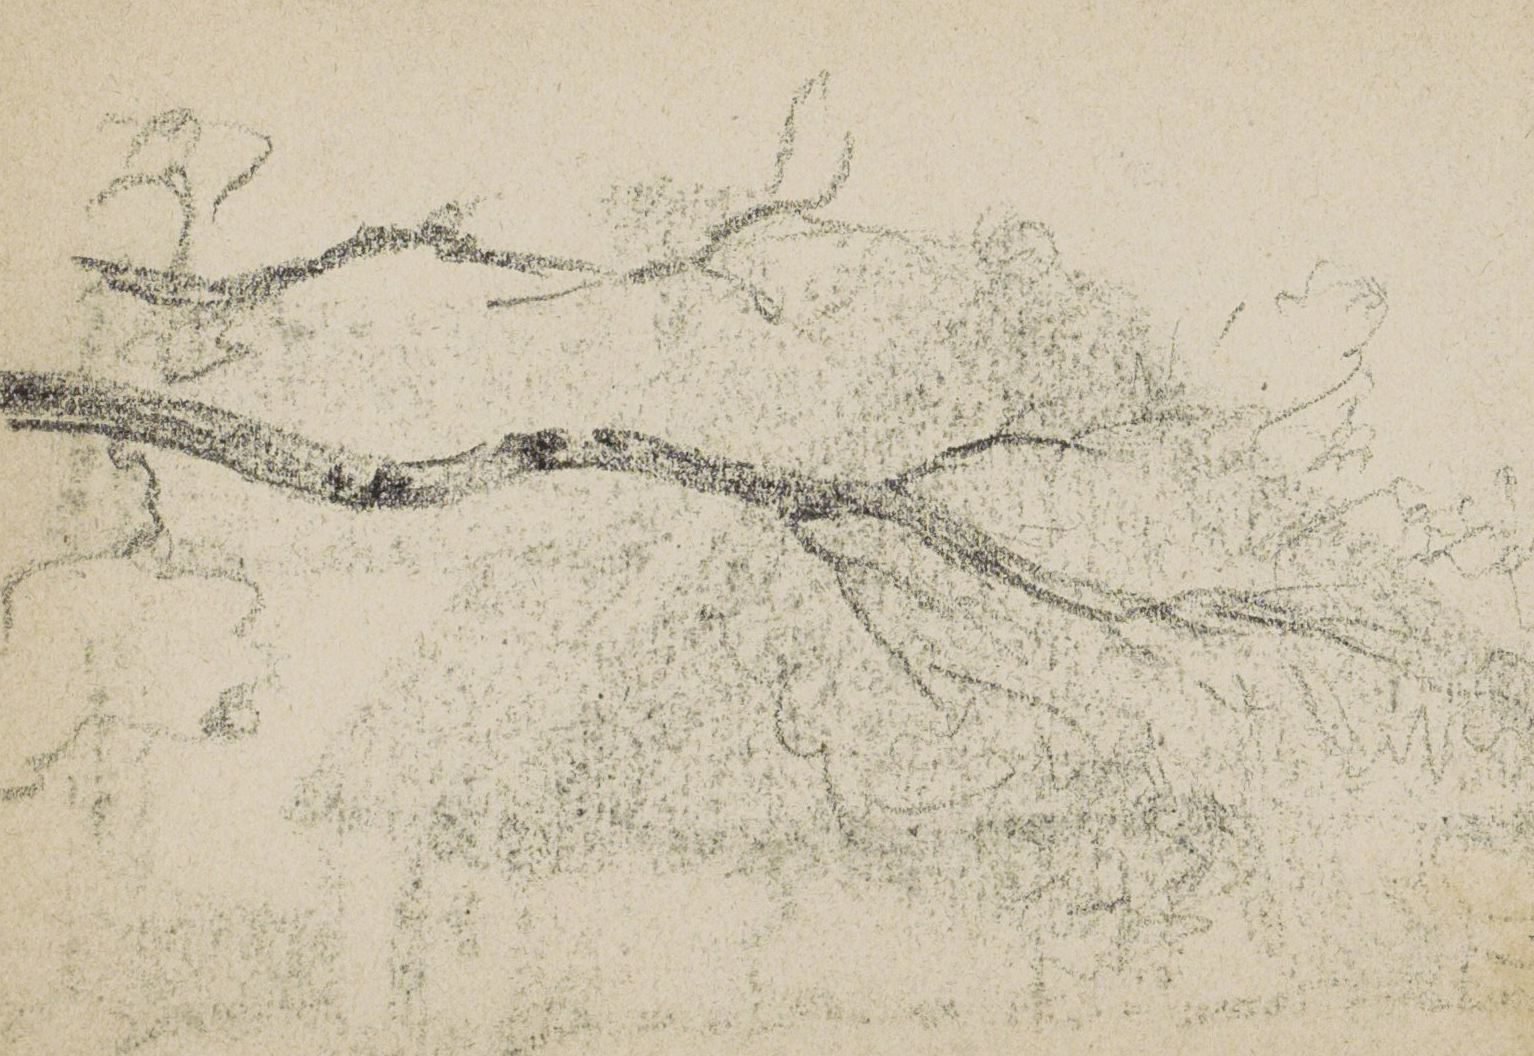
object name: sketchbook leaf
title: Bomen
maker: willem cornelis rip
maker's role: draughtsman, painter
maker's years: 1856-1922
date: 1896-1897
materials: chalk, paper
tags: trees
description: Blad 34 verso uit een schetsboek met 44 bladen.